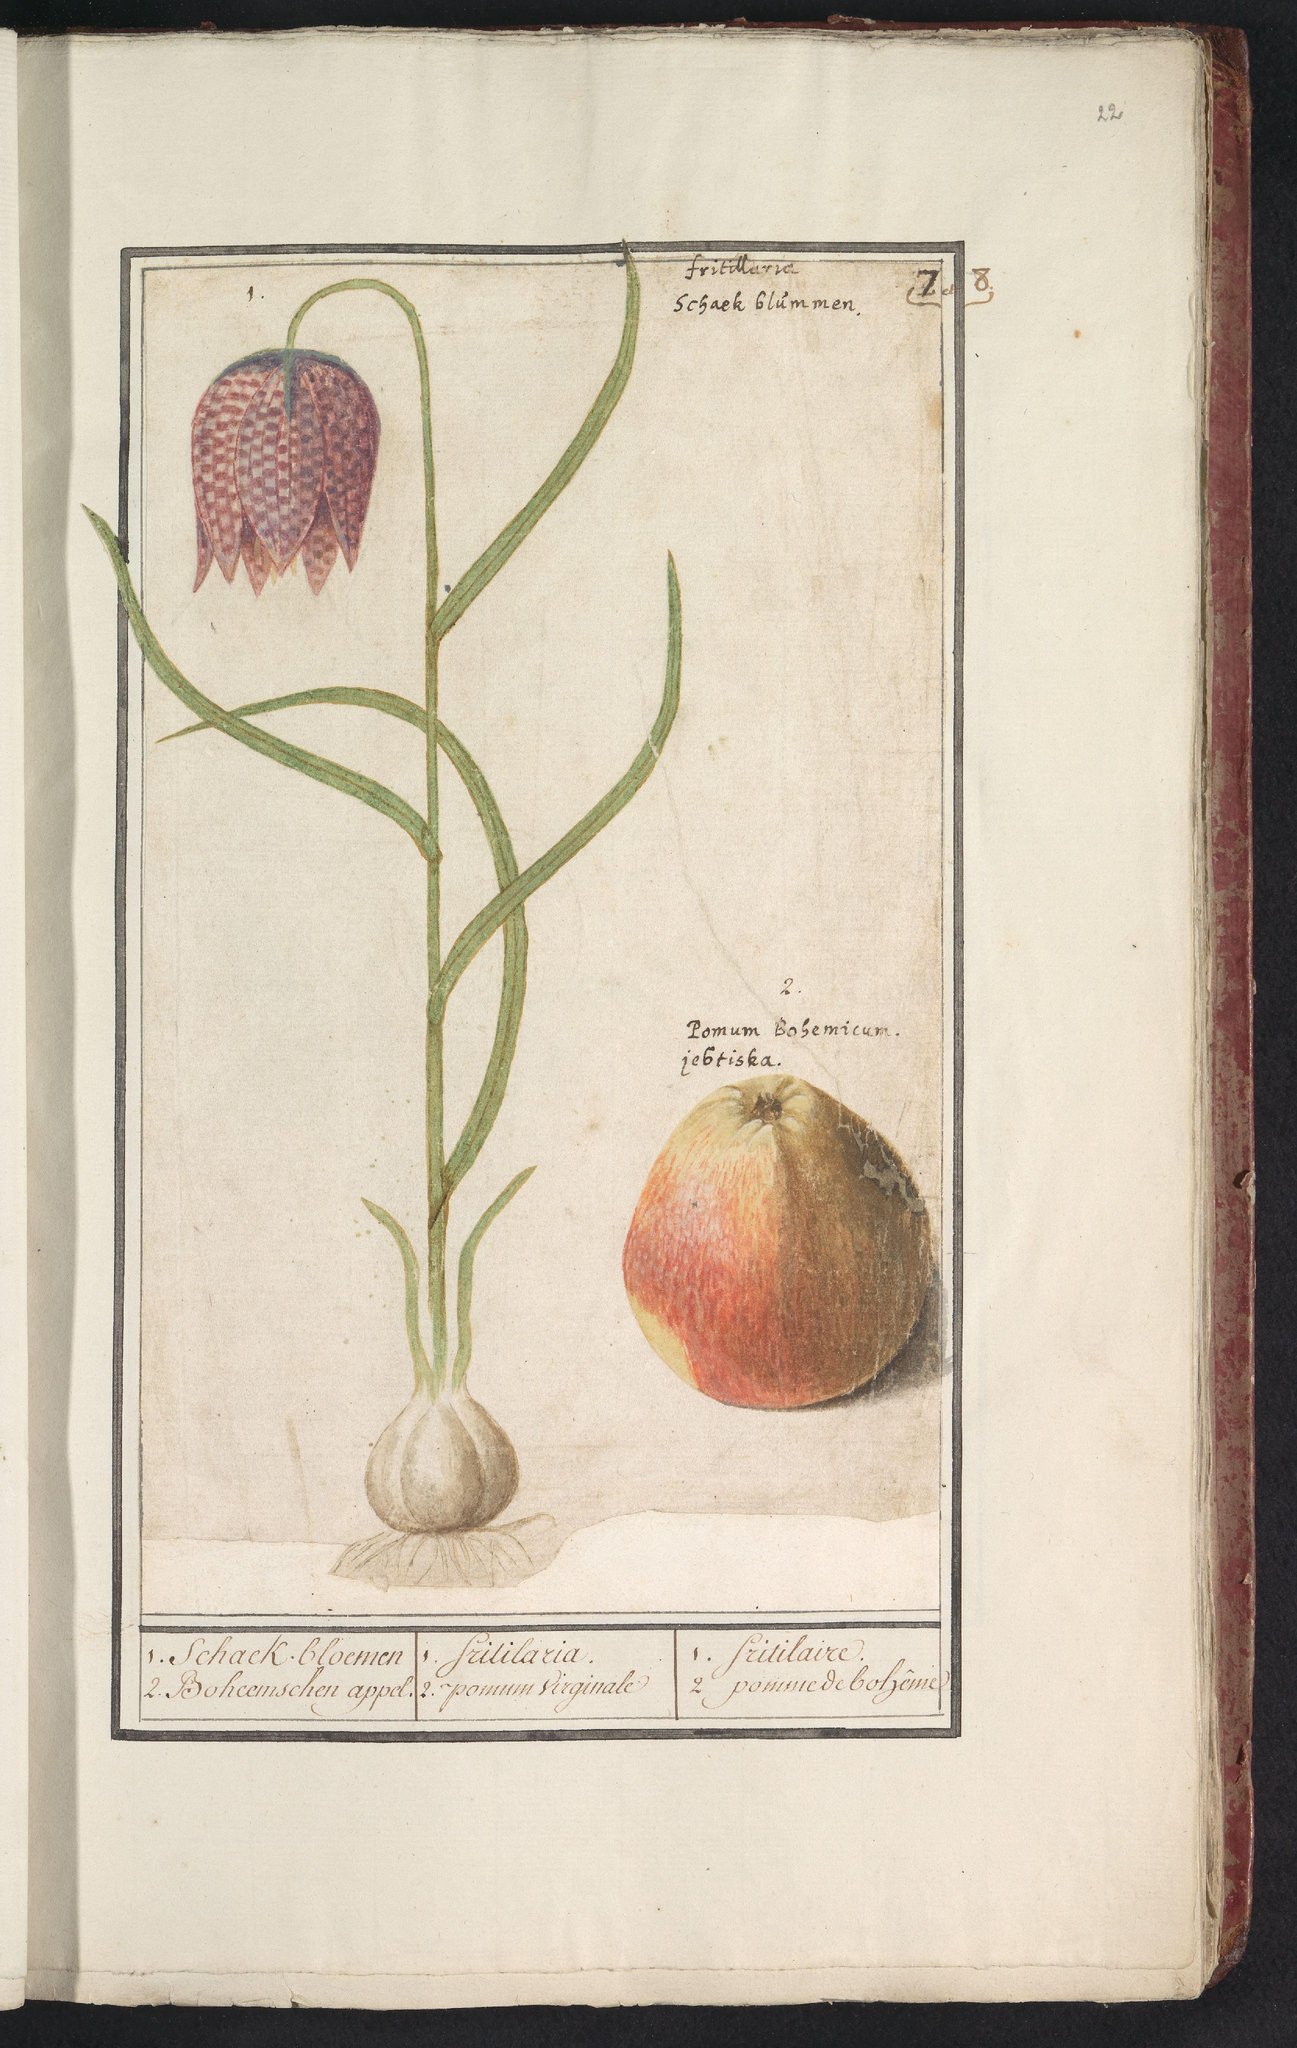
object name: drawing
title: 1. Schaek-bloemen 2. Boheemschen appel. / 1. fritilaria. 2. pomum Virginale / 1. fritilaire. 2 pomme de bohême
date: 1596-1610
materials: chalk, paint, ink, paper, watercolor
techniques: brush, pen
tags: fruits: apple, flowers: snake's head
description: Kievitsbloem en een (Boheemse) appel. Genummerd rechtsboven: 7 en 8. Met de Latijnse namen. Onderdeel van het eerste album met tekeningen van bloemen en planten. Achtste van twaalf albums met tekeningen van dieren, vogels en planten bekend rond 1600, gemaakt in opdracht van keizer Rudolf II. Met toelichting in Nederlands, Latijn en Frans.